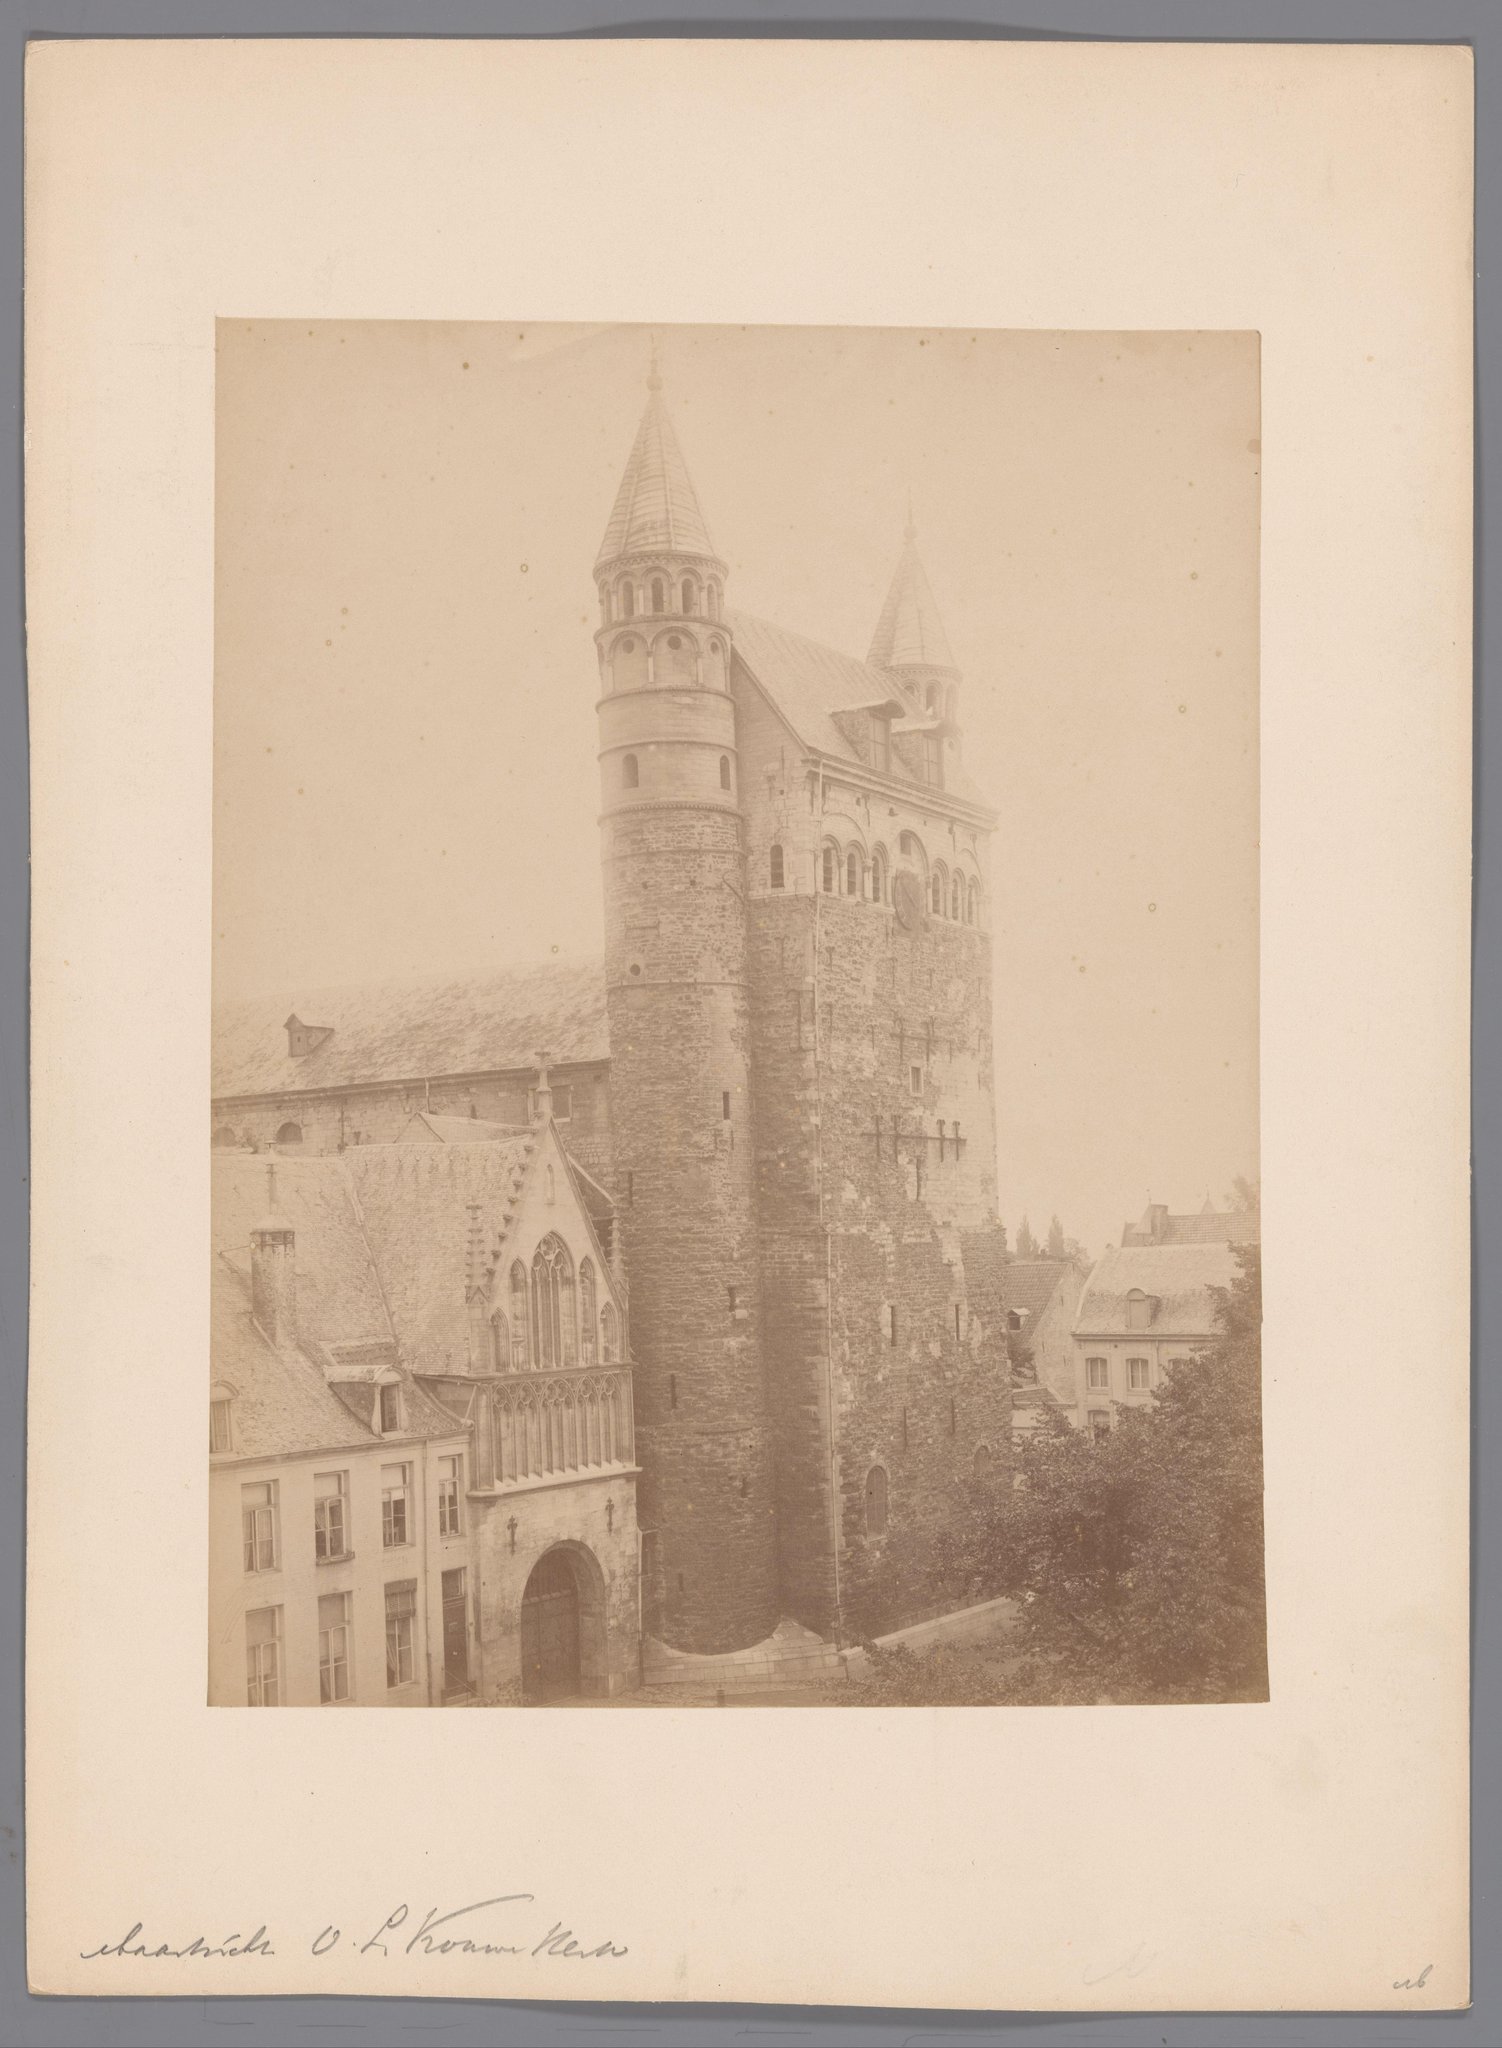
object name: photograph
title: Toren van de Onze-Lieve-Vrouwebasiliek te Maastricht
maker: anoniem (monumentenzorg)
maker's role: fotograaf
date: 1893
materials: cardboard, photographic support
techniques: albumen print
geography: maastricht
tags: parts of church exterior and annexes: tower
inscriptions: annotation: ‘Maastricht (L.)/ Toren v/d O.L. Vrouwekerk/ Mei 1893’, annotation: ‘Maastricht O.L. Vrouwekerk’